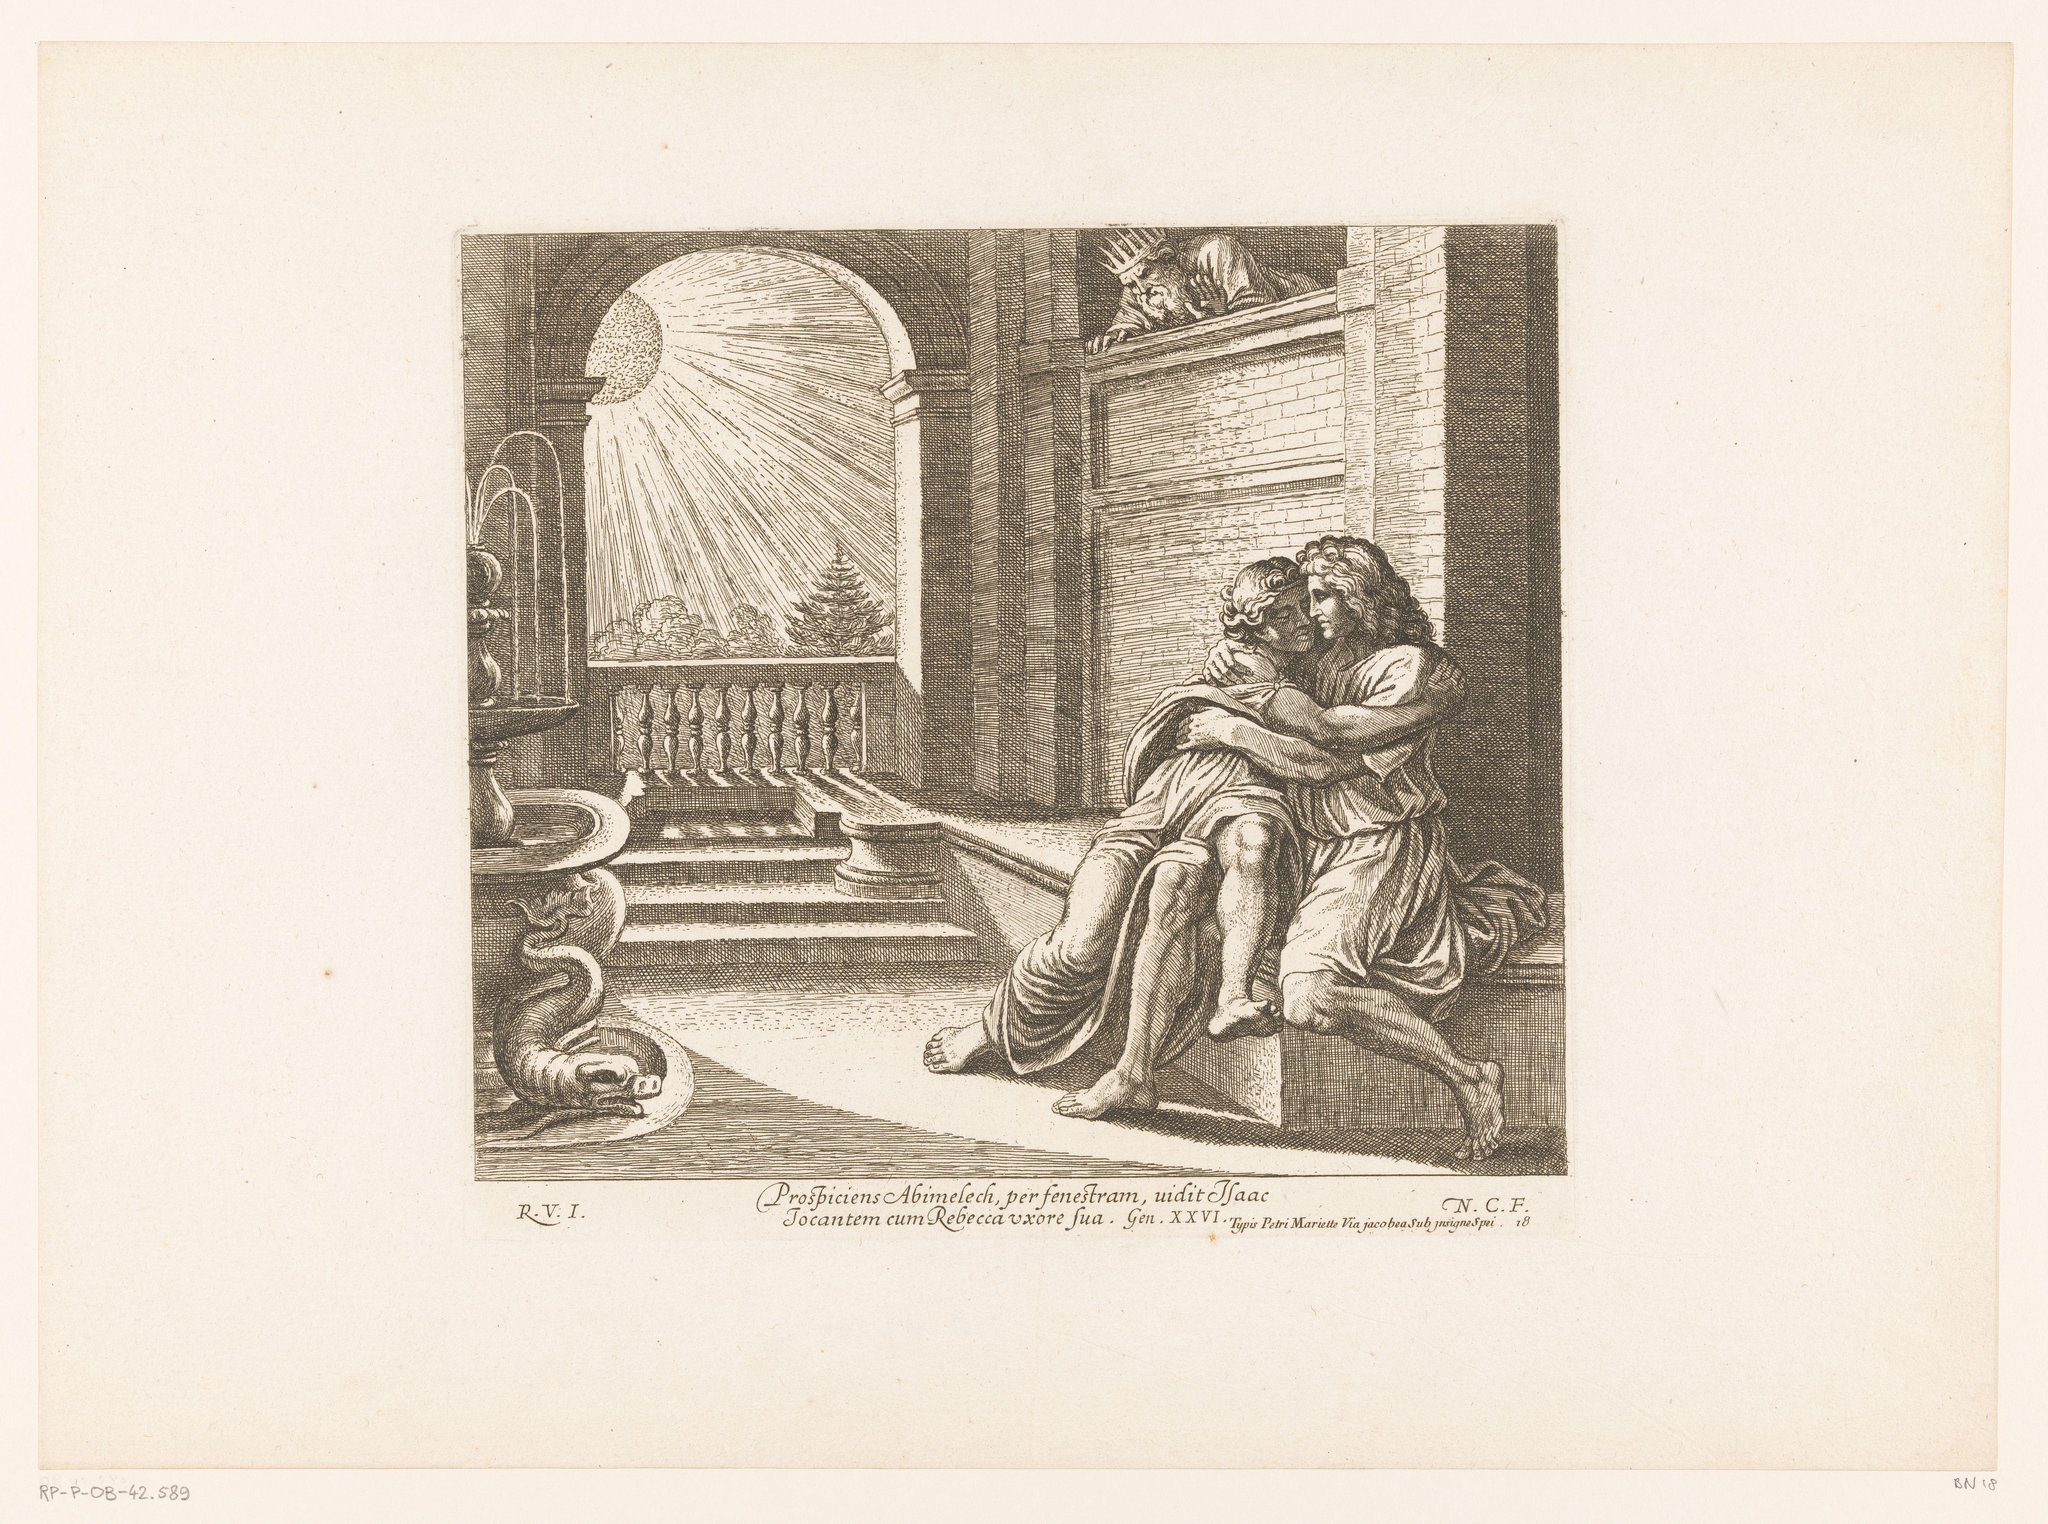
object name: print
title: Isaak en Rebekka bespied door Abimelech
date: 1649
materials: paper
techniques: etching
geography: france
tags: king abimelech, looking down from his window, sees isaac and rebekah making love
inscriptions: collector's mark: Lugt 2228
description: Prent uit de Sacrae Historiae Acta a Raphael Urbin in Vaticanis xystis ad picturae miraculum expressa, ook bekend als de Rafaël Bijbel. De serie bestaat uit 54 platen, waarvan twee titelprenten, de eerste met een opdracht aan Rafaël, de tweede met een opdracht aan Renard. De overige 52 platen betreffen composities naar schilderingen in de Loggia van Rafaël in het Vaticaan. De serie werd in 1649 uitgegeven door Pierre Mariette te Parijs.